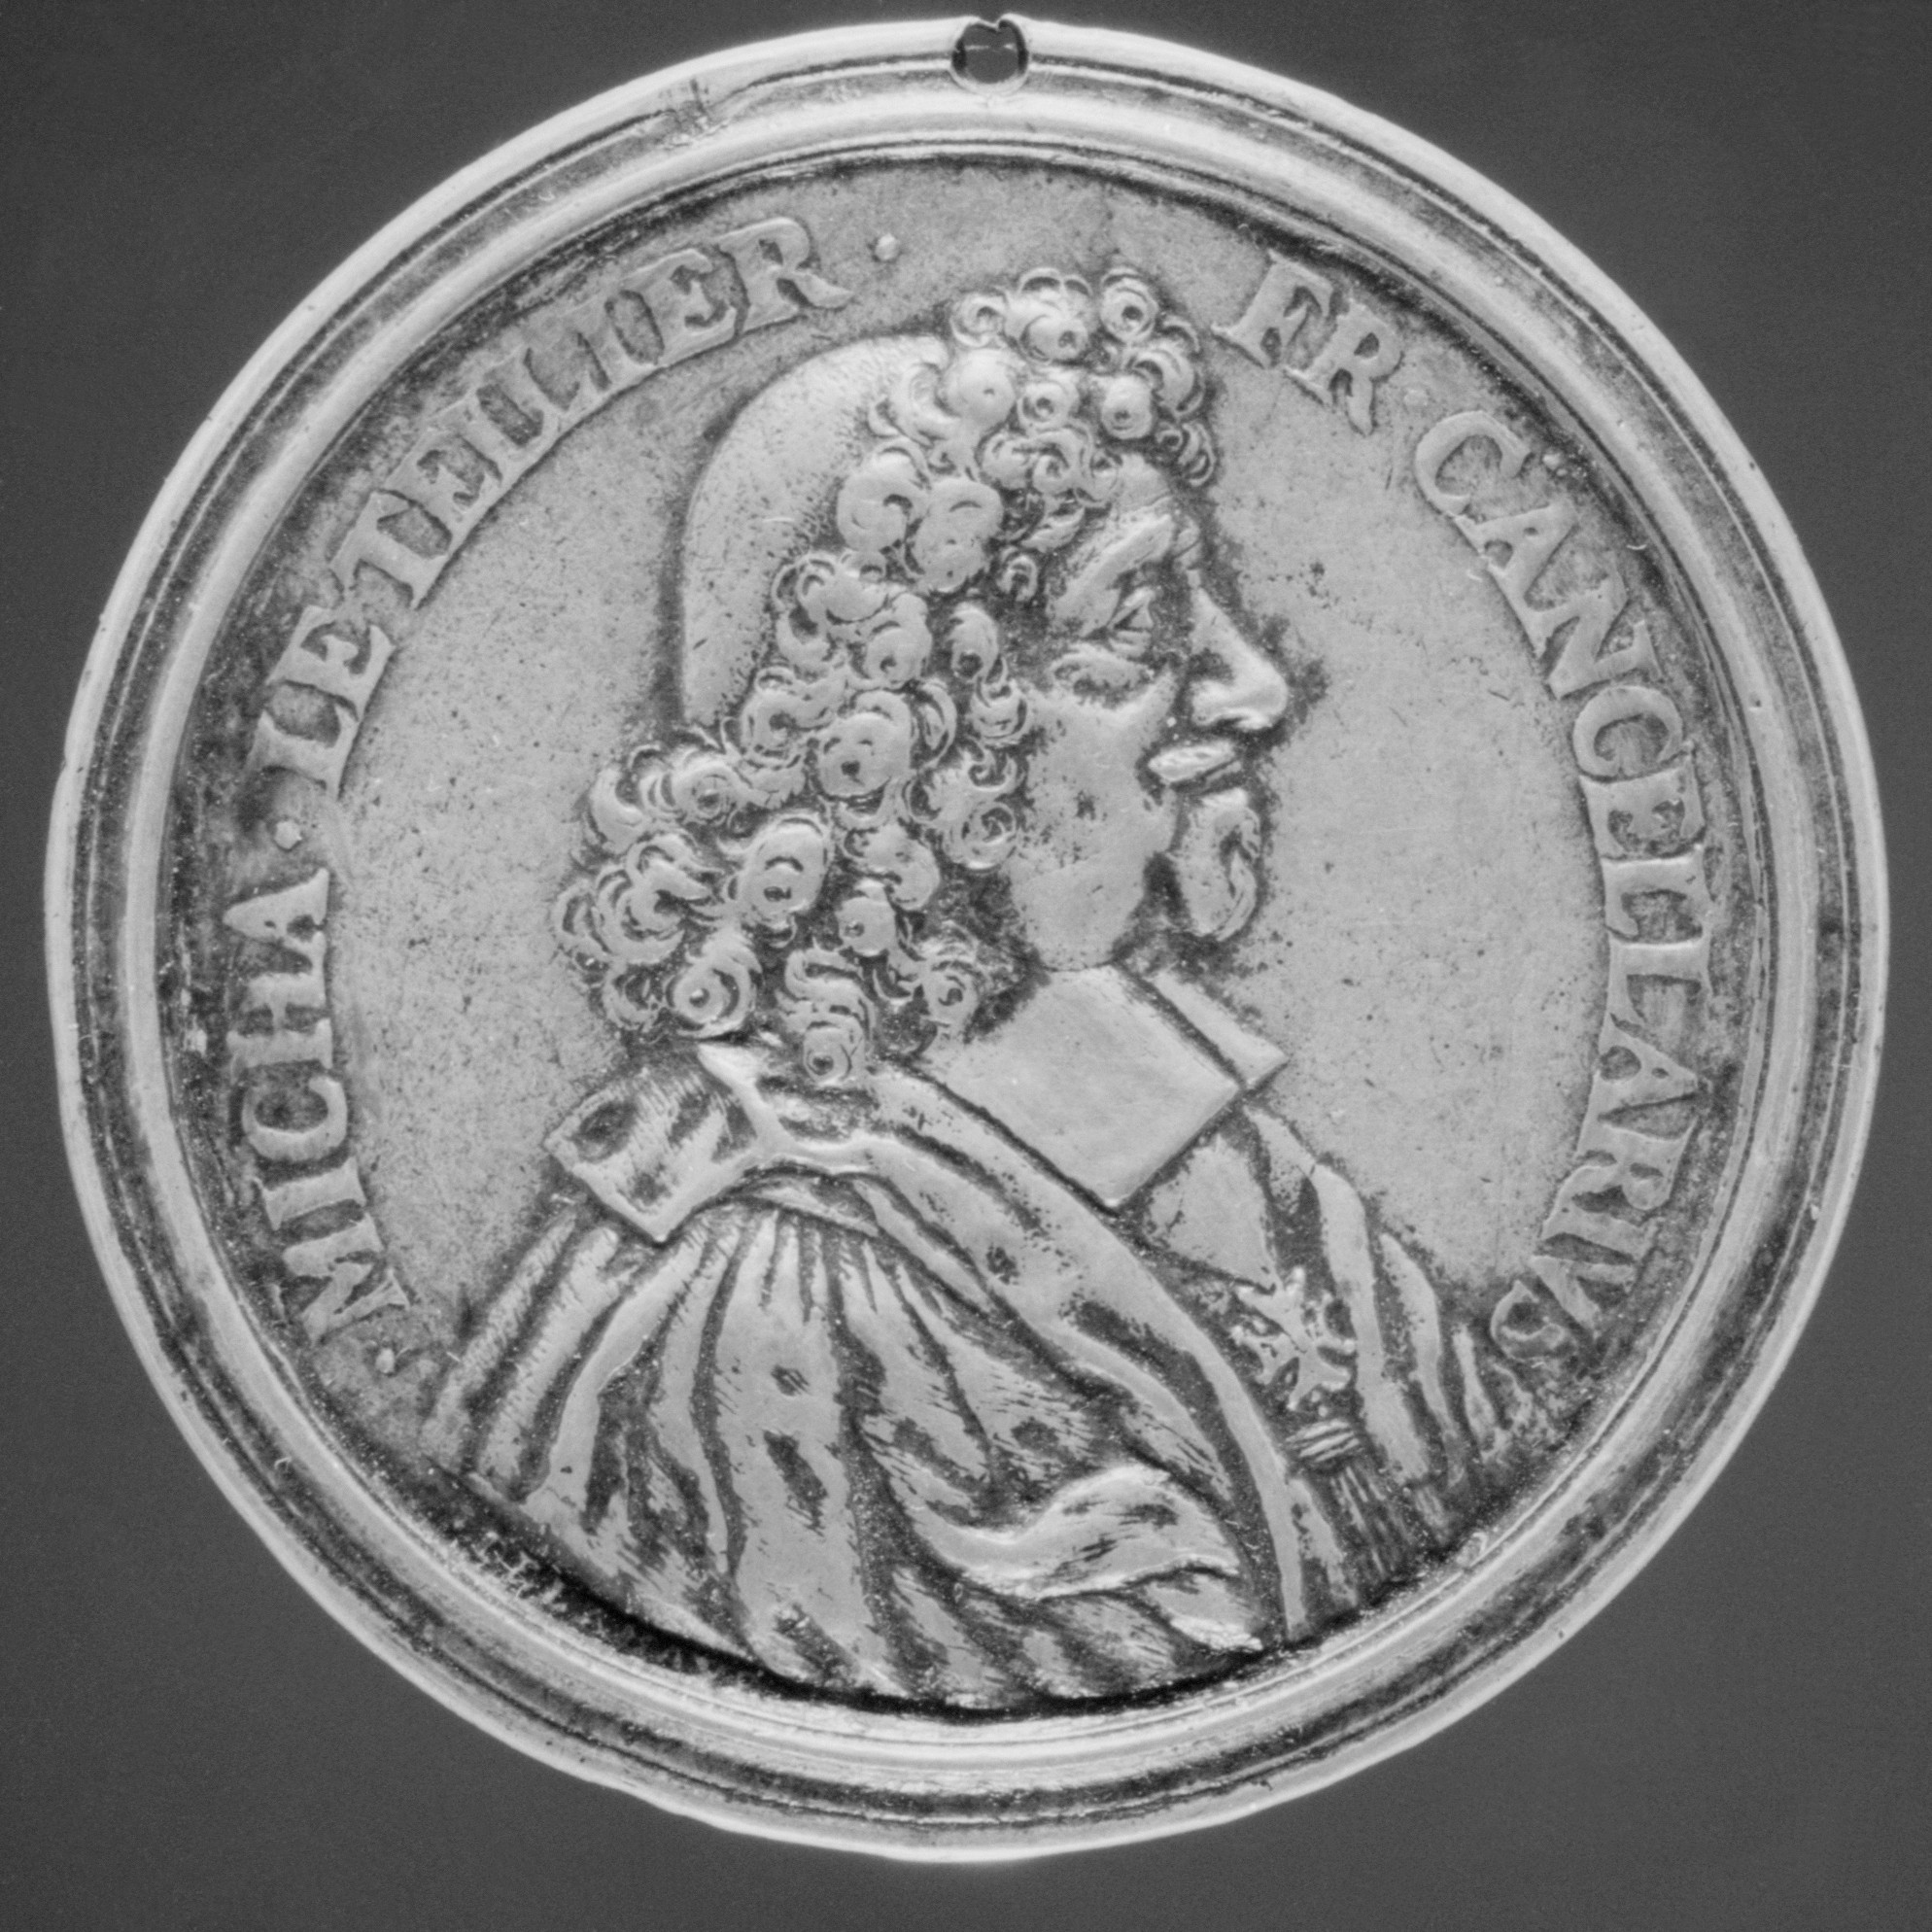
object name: medal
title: Michel Le Tellier (1603–85), Chancellor of France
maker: nicolas de la haye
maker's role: artist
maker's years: 1684-1703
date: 1677-1685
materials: bronze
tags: men,profiles